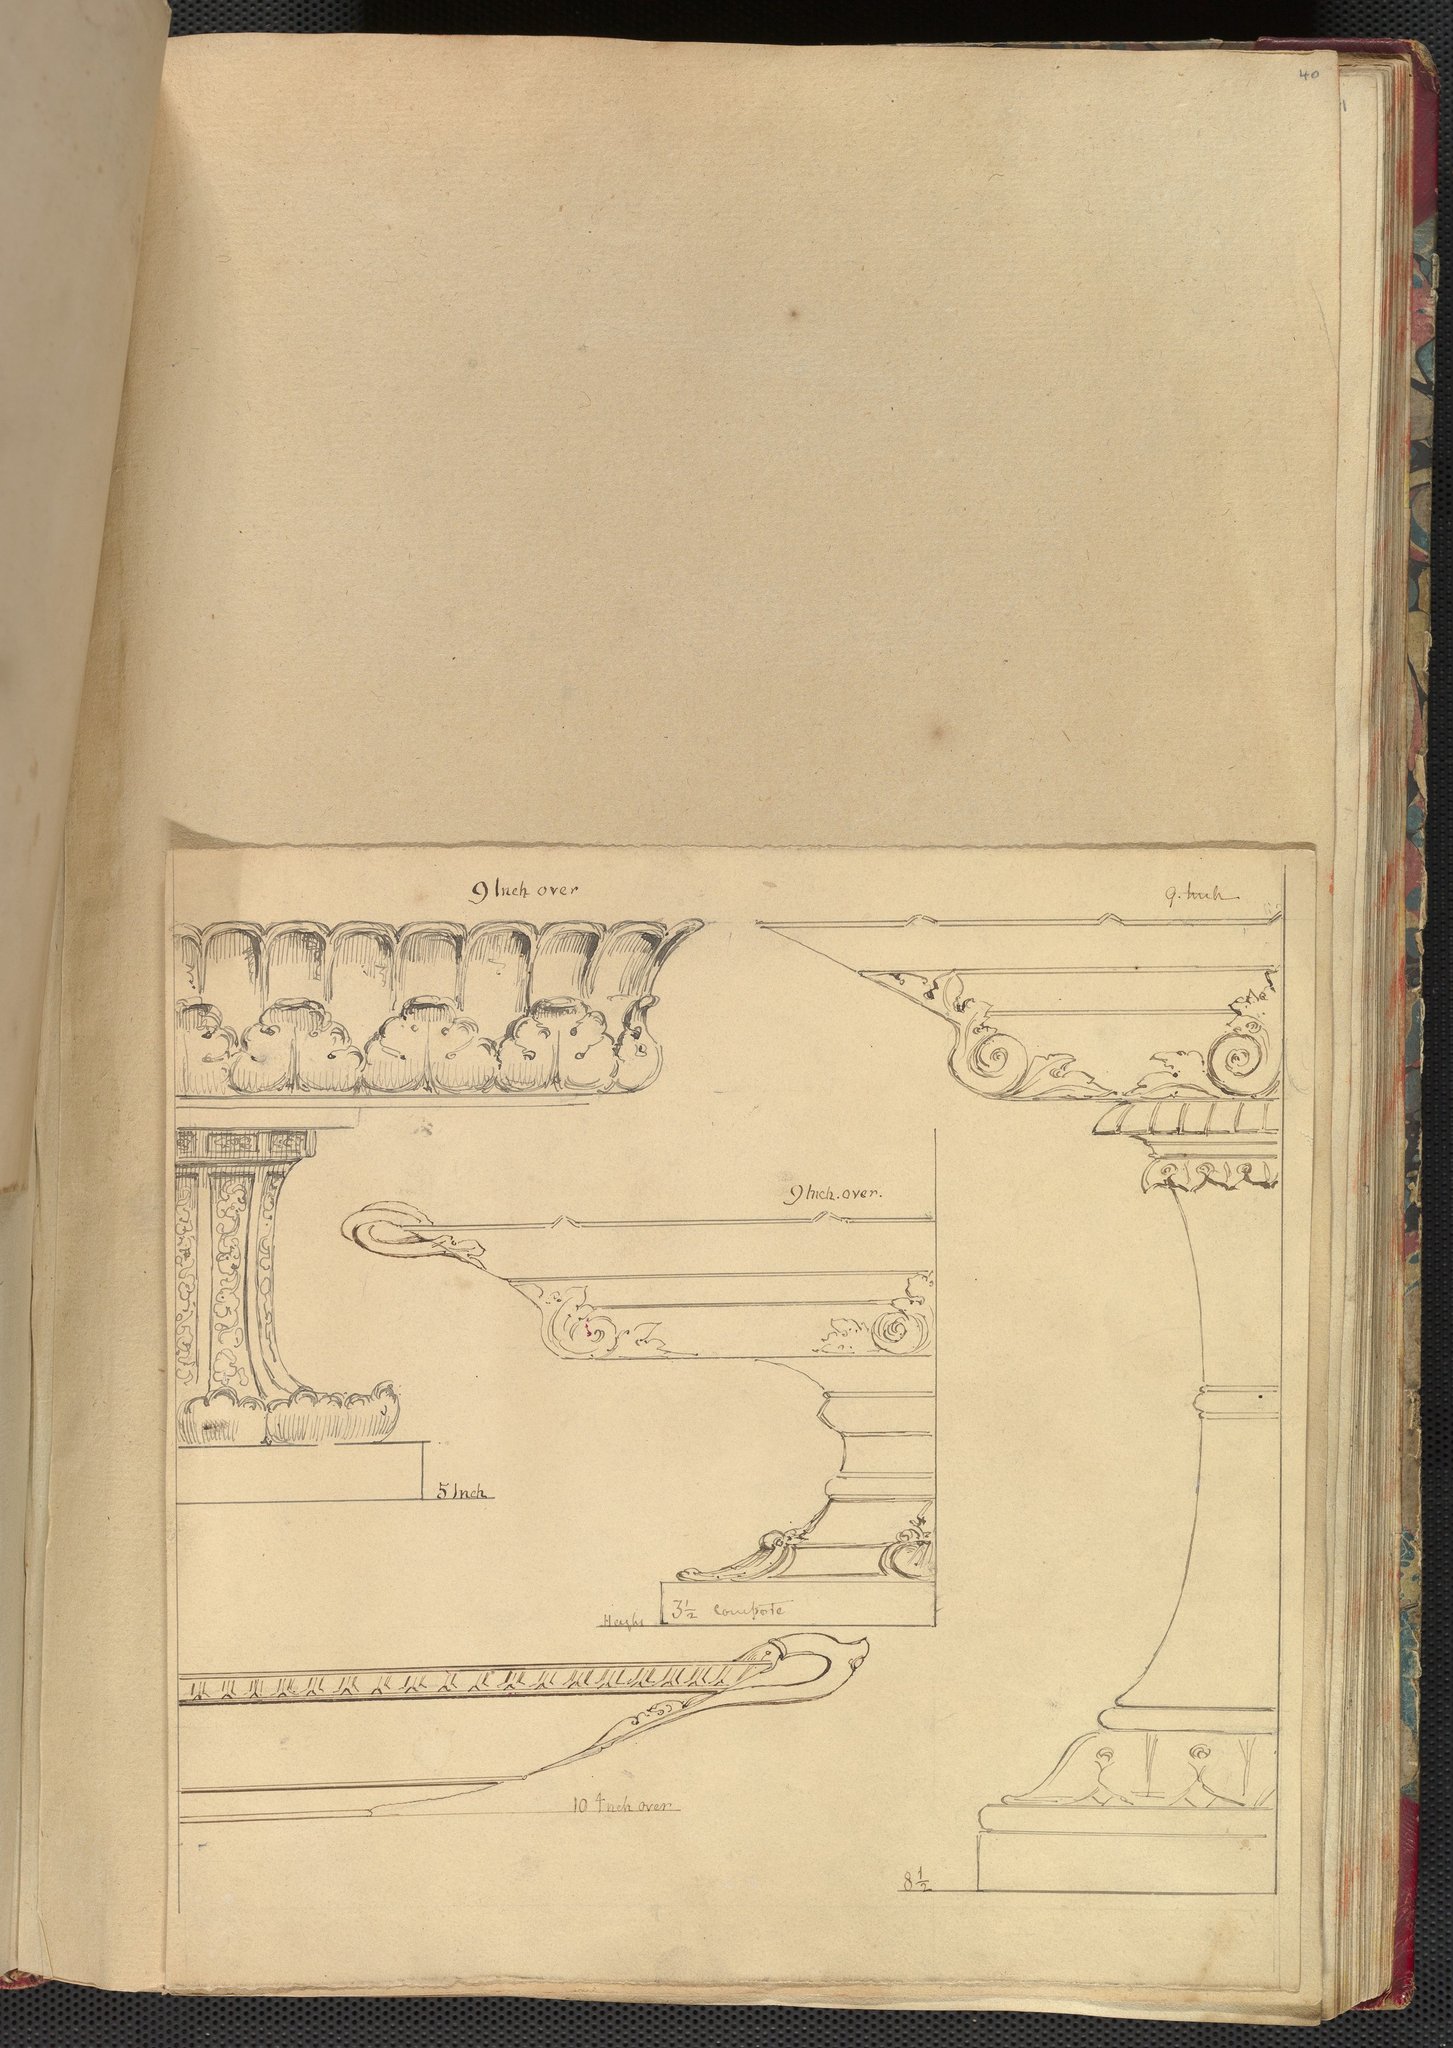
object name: drawing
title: Designs for Dishes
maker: alfred henry forrester [alfred crowquill]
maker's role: artist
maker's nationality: british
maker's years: 1804-1872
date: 1845-1855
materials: ink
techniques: pen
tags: ornament